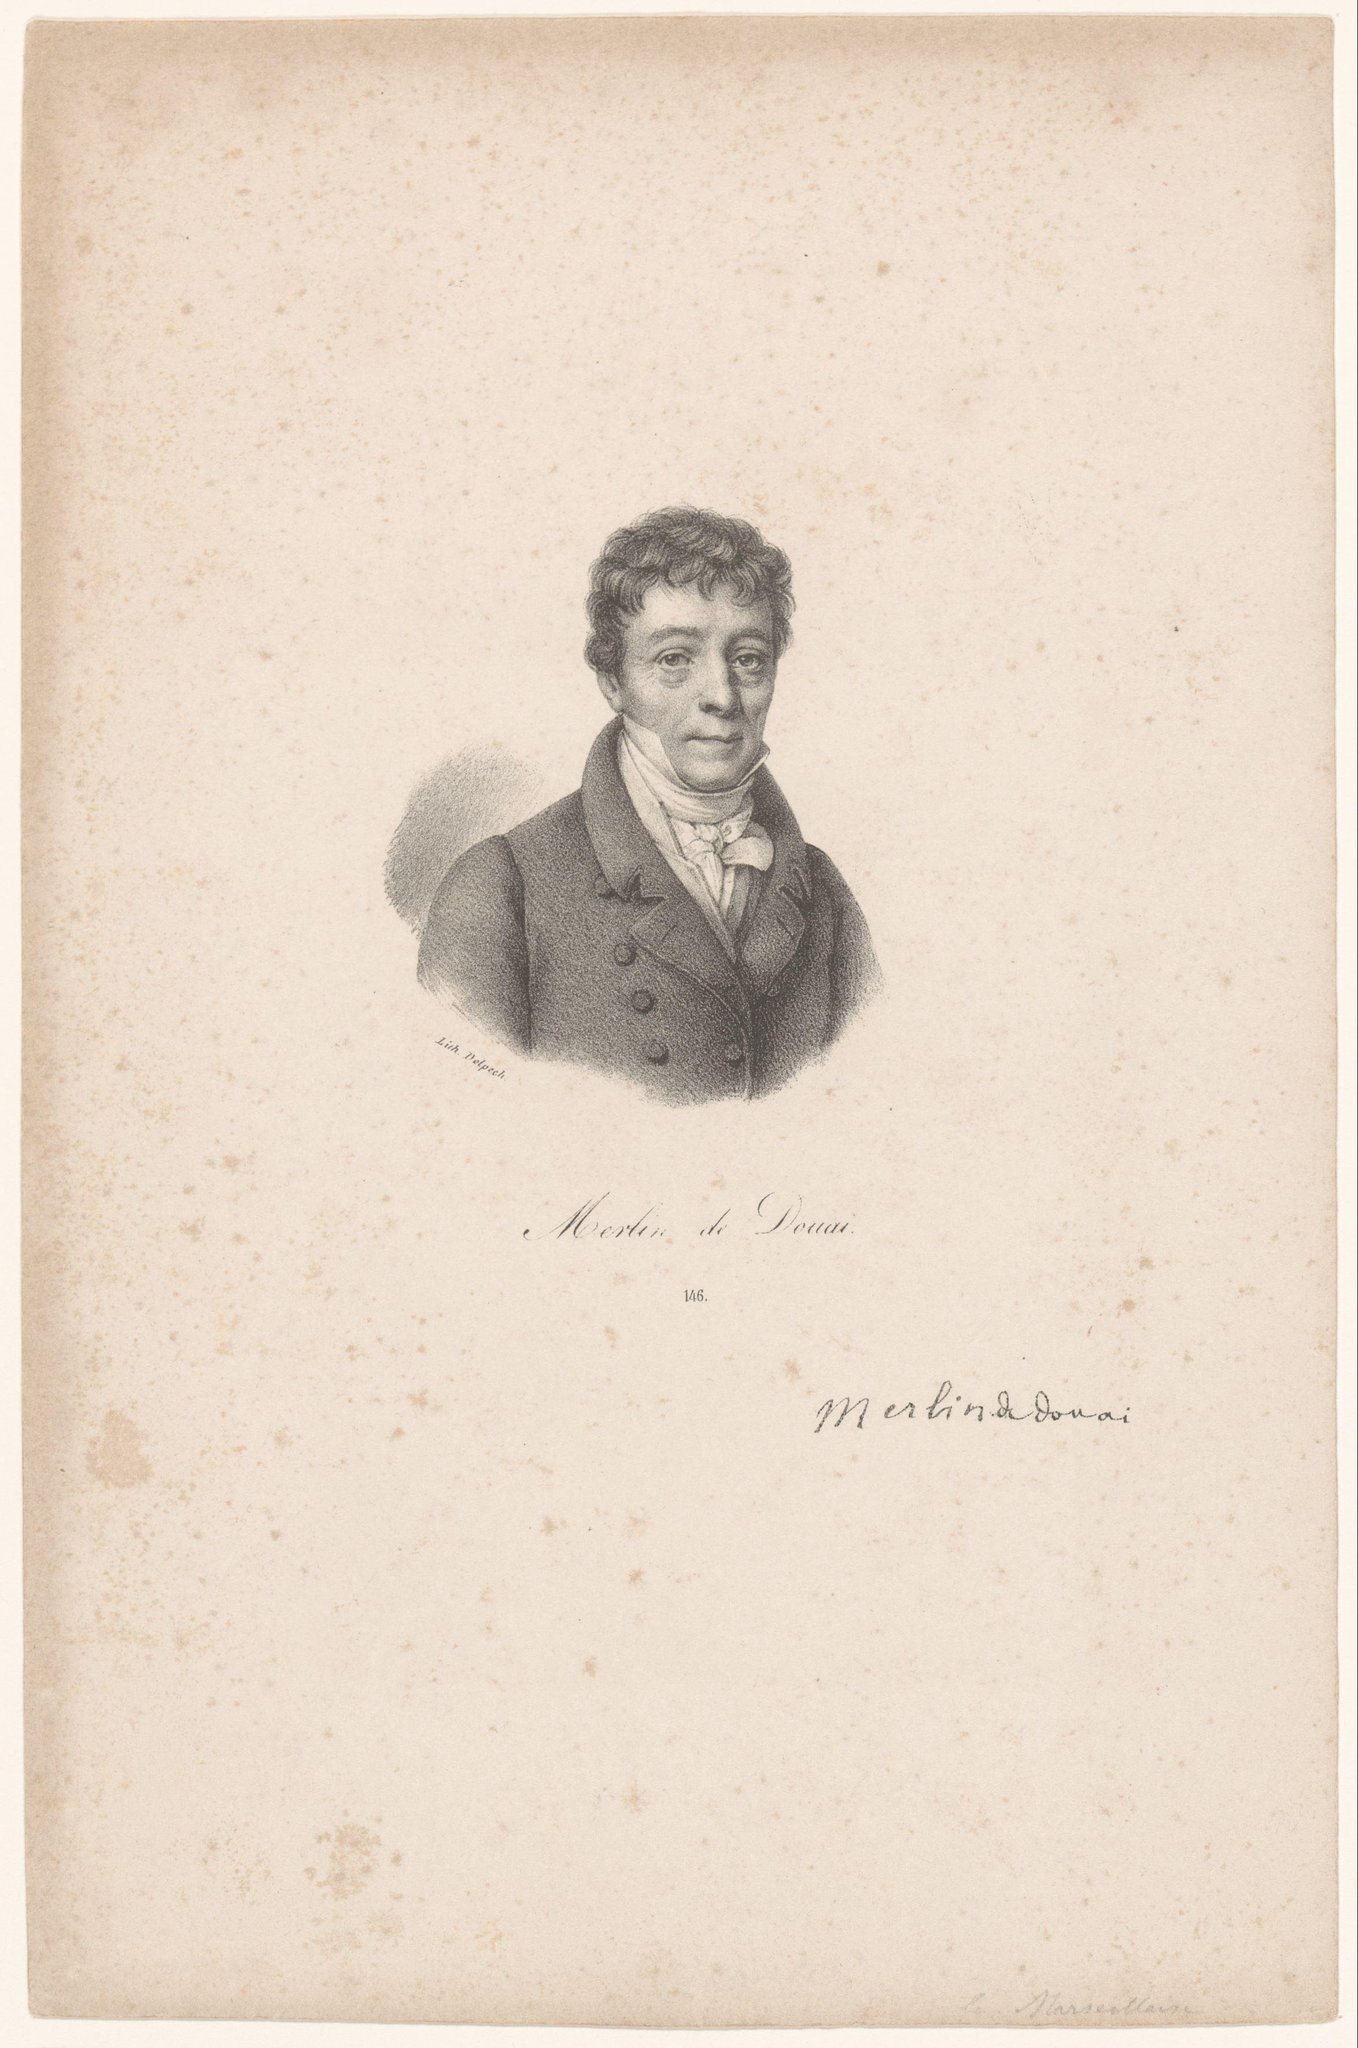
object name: print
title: Portret van Philippe-Antoine Merlin de Douai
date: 1818-1842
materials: paper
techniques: lithograph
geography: paris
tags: paris, historical persons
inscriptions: collector's mark: Lugt 2228a